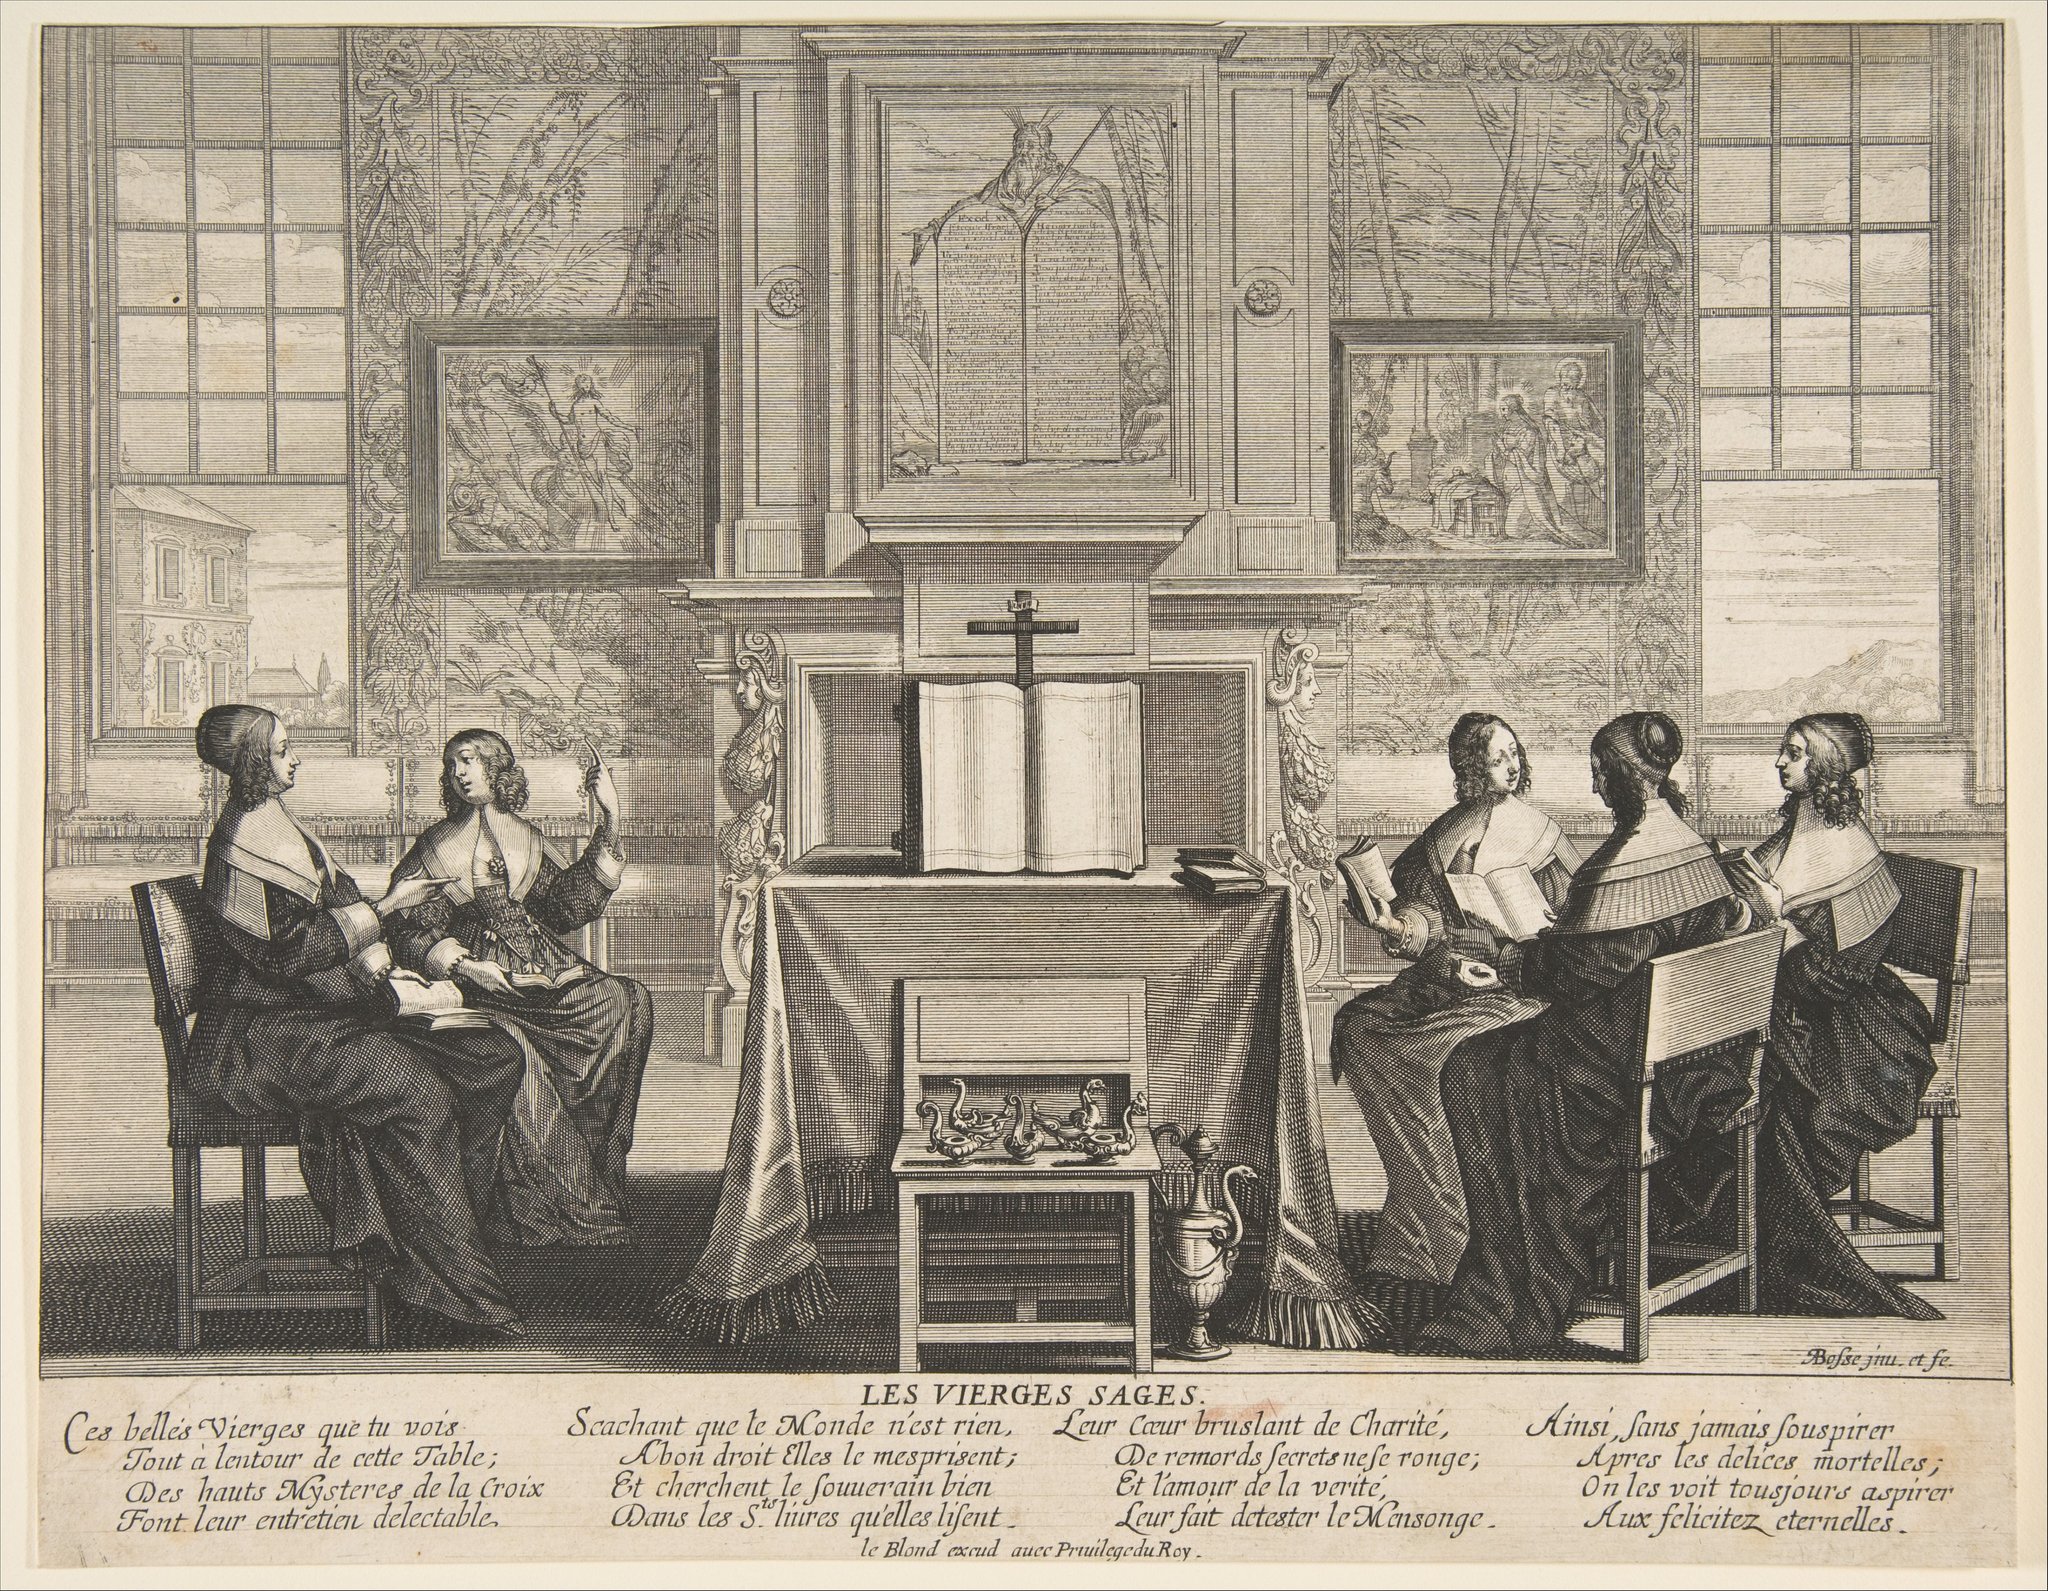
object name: print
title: The Wise Virgins Conversing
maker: abraham bosse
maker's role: artist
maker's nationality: french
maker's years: 1602-1676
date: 1635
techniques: etching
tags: books,women,cross